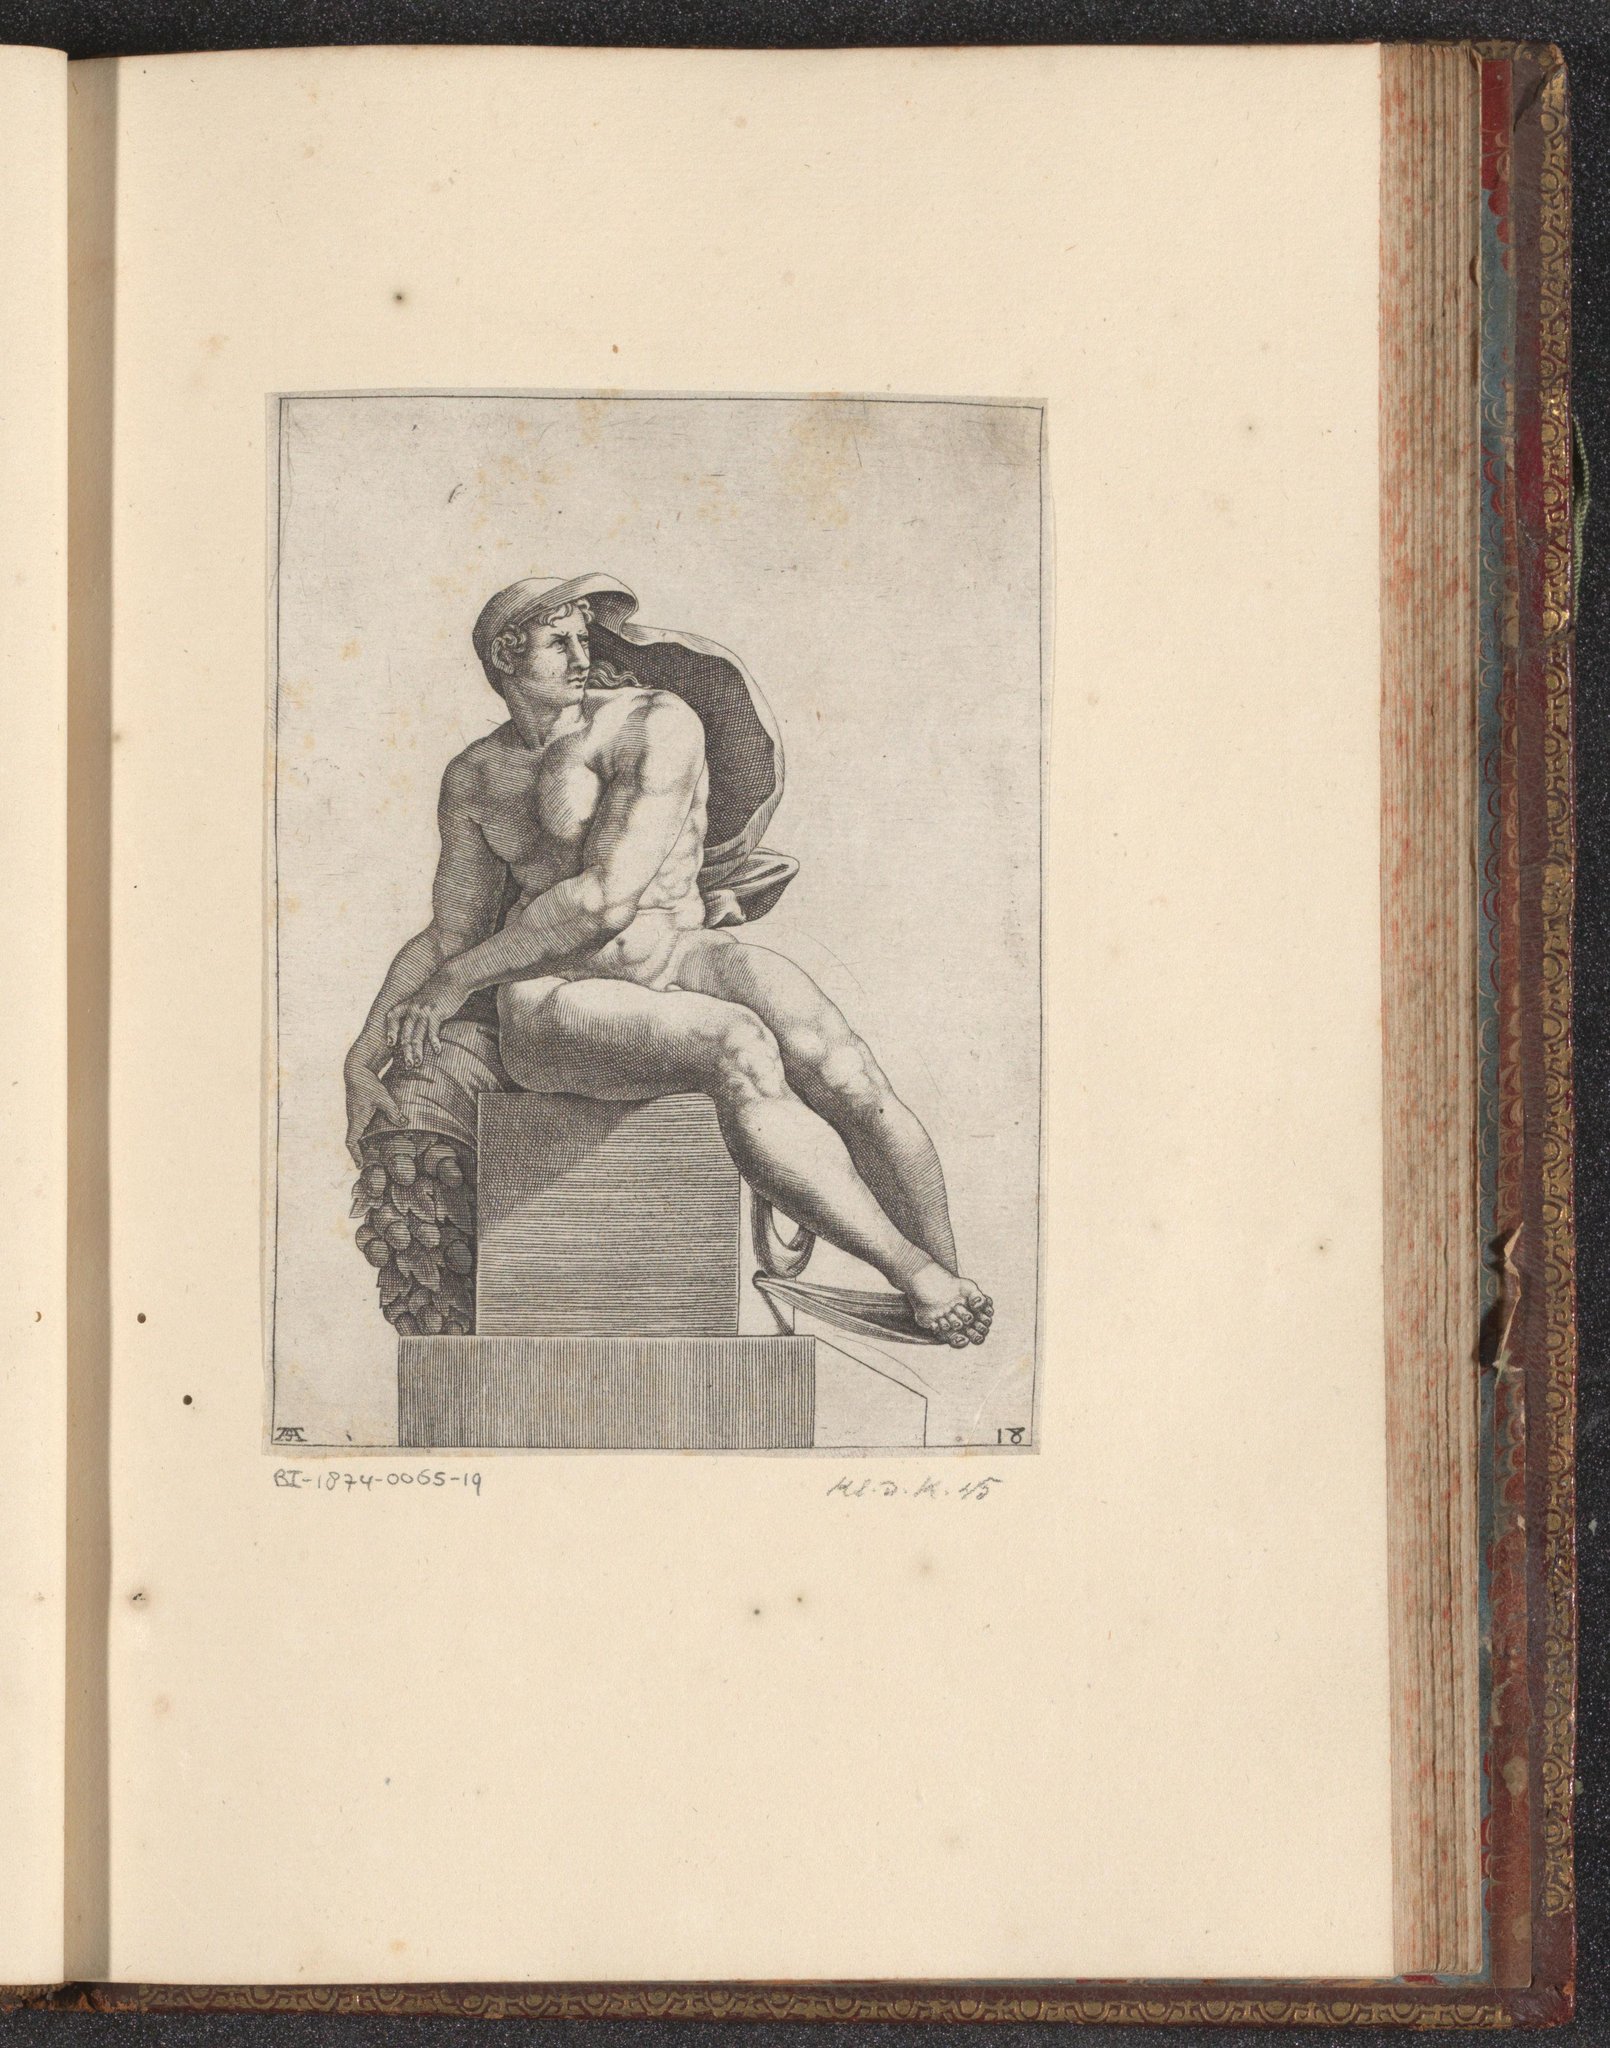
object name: album leaf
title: Zittend naakt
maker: adamo scultori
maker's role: painter, print maker, sculptor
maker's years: 1530-1585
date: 1585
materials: paper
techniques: engraving, intaglio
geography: vatican city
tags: the (nude) human figure; 'corpo humano' (ripa), fruits: acorn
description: Zittende naakte man, naar rechts gedraaid, met een doek over zijn hoofd en een guirlande van eikels. Eén van de 'ignudi' (naakte mannen) van Michelangelo's plafondschildering. Genummerd rechtsonder: 18. De prent maakt deel uit van een album.